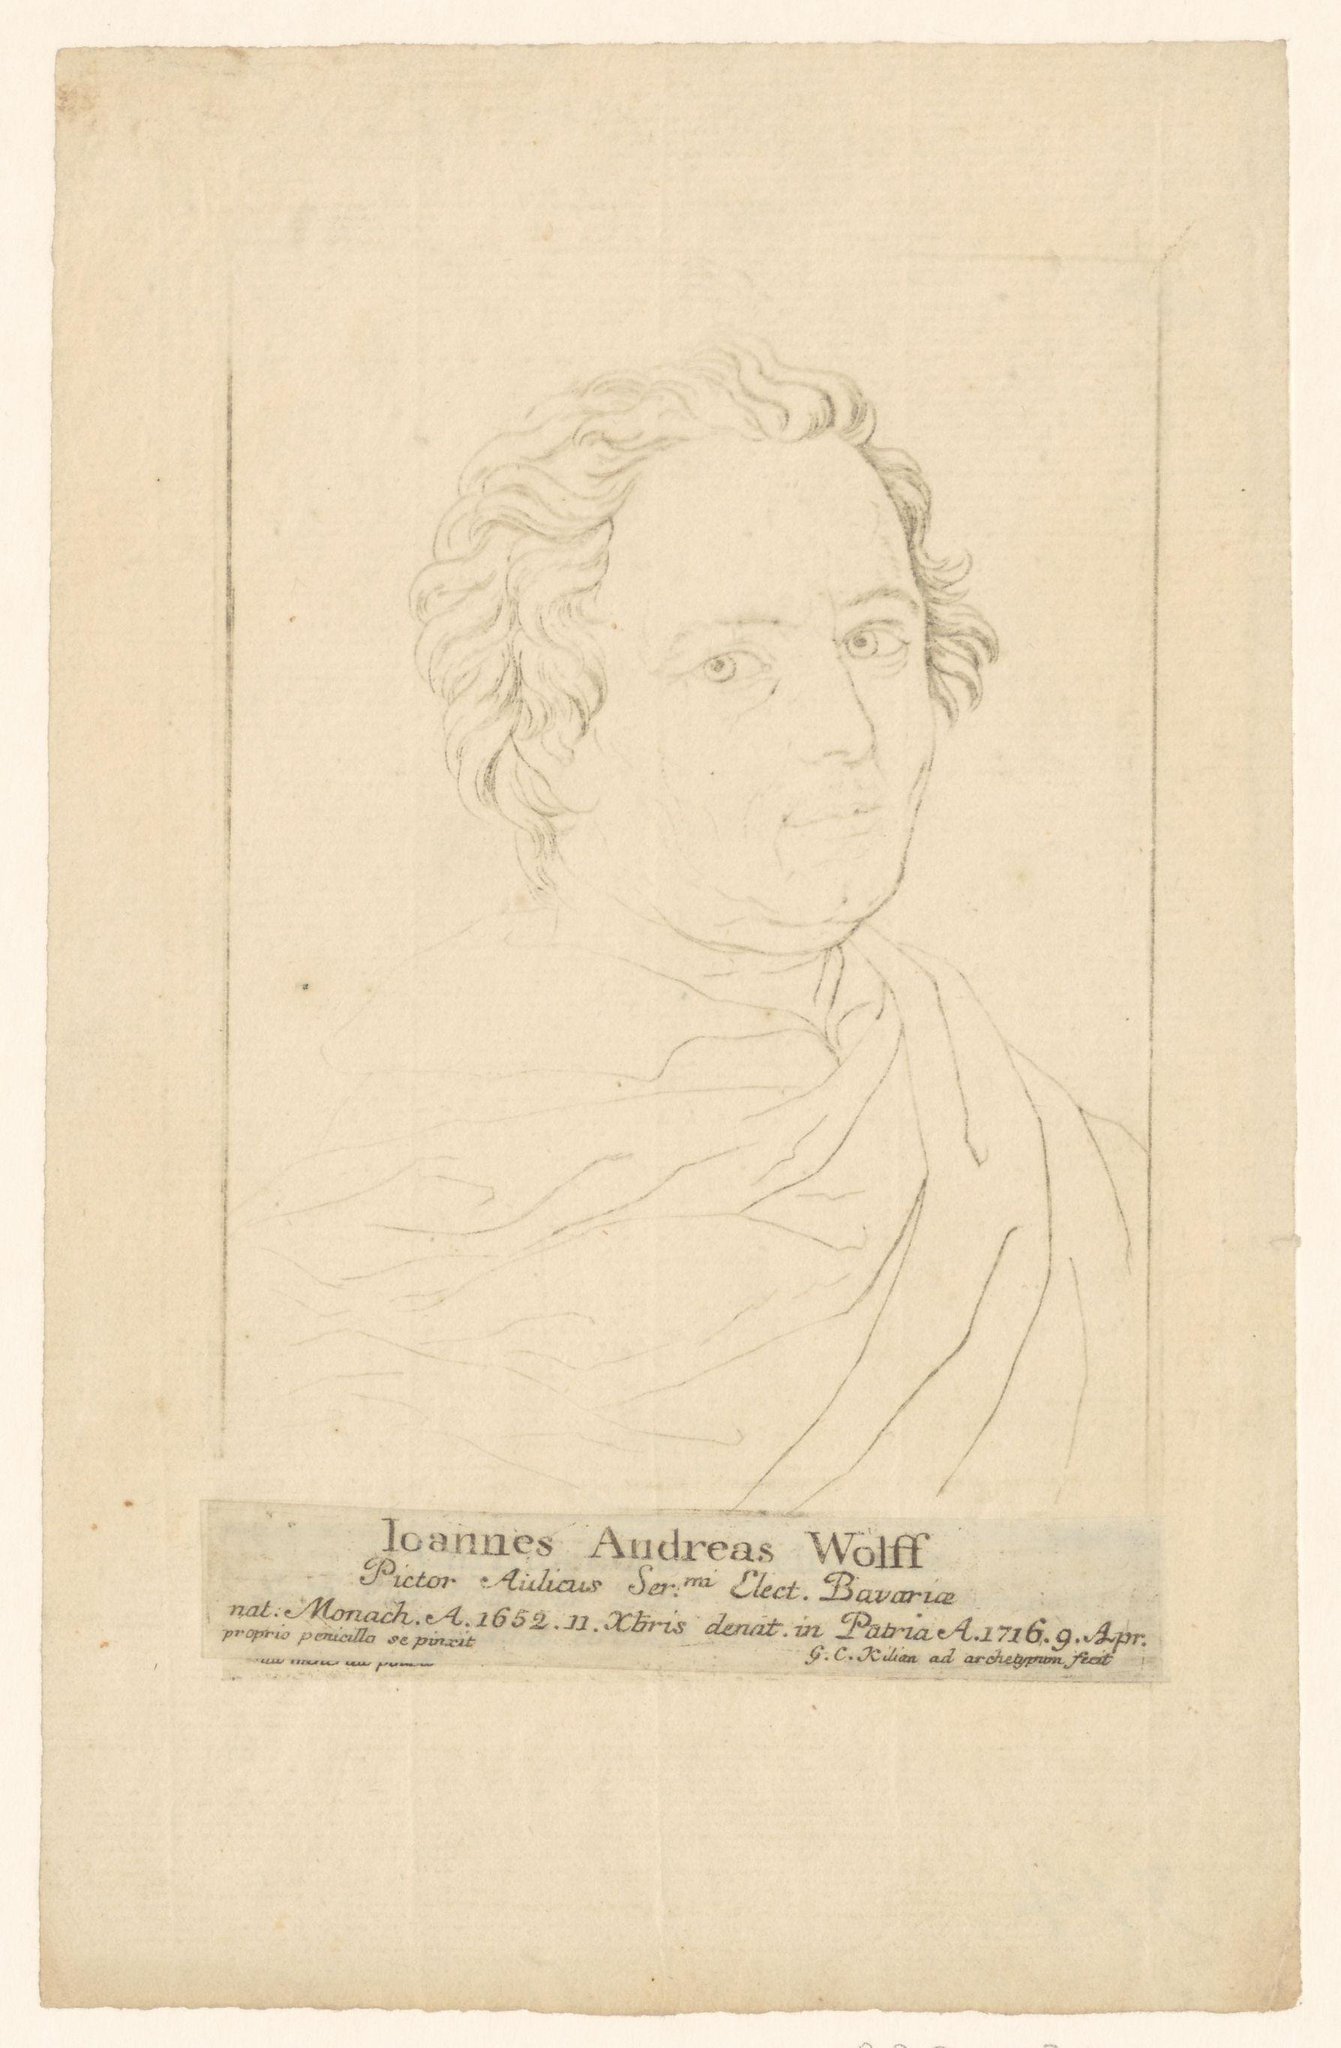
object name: print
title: Portret van Johann Andreas Wolff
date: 1719-1781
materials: paper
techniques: etching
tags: johann andreas wolff, historical persons, portrait, self-portrait of painter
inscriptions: collector's mark: Lugt 2228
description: Het onderschrift waar overheen is geplakt geeft een andere naam aan, maar kan als incorrect worden beschouwd aangezien de prent Andreas Wolff verbeeld. Het zelfportret waarop deze prent is gebaseerd bevindt zich in de Staatliche Graphische Sammlung, München.